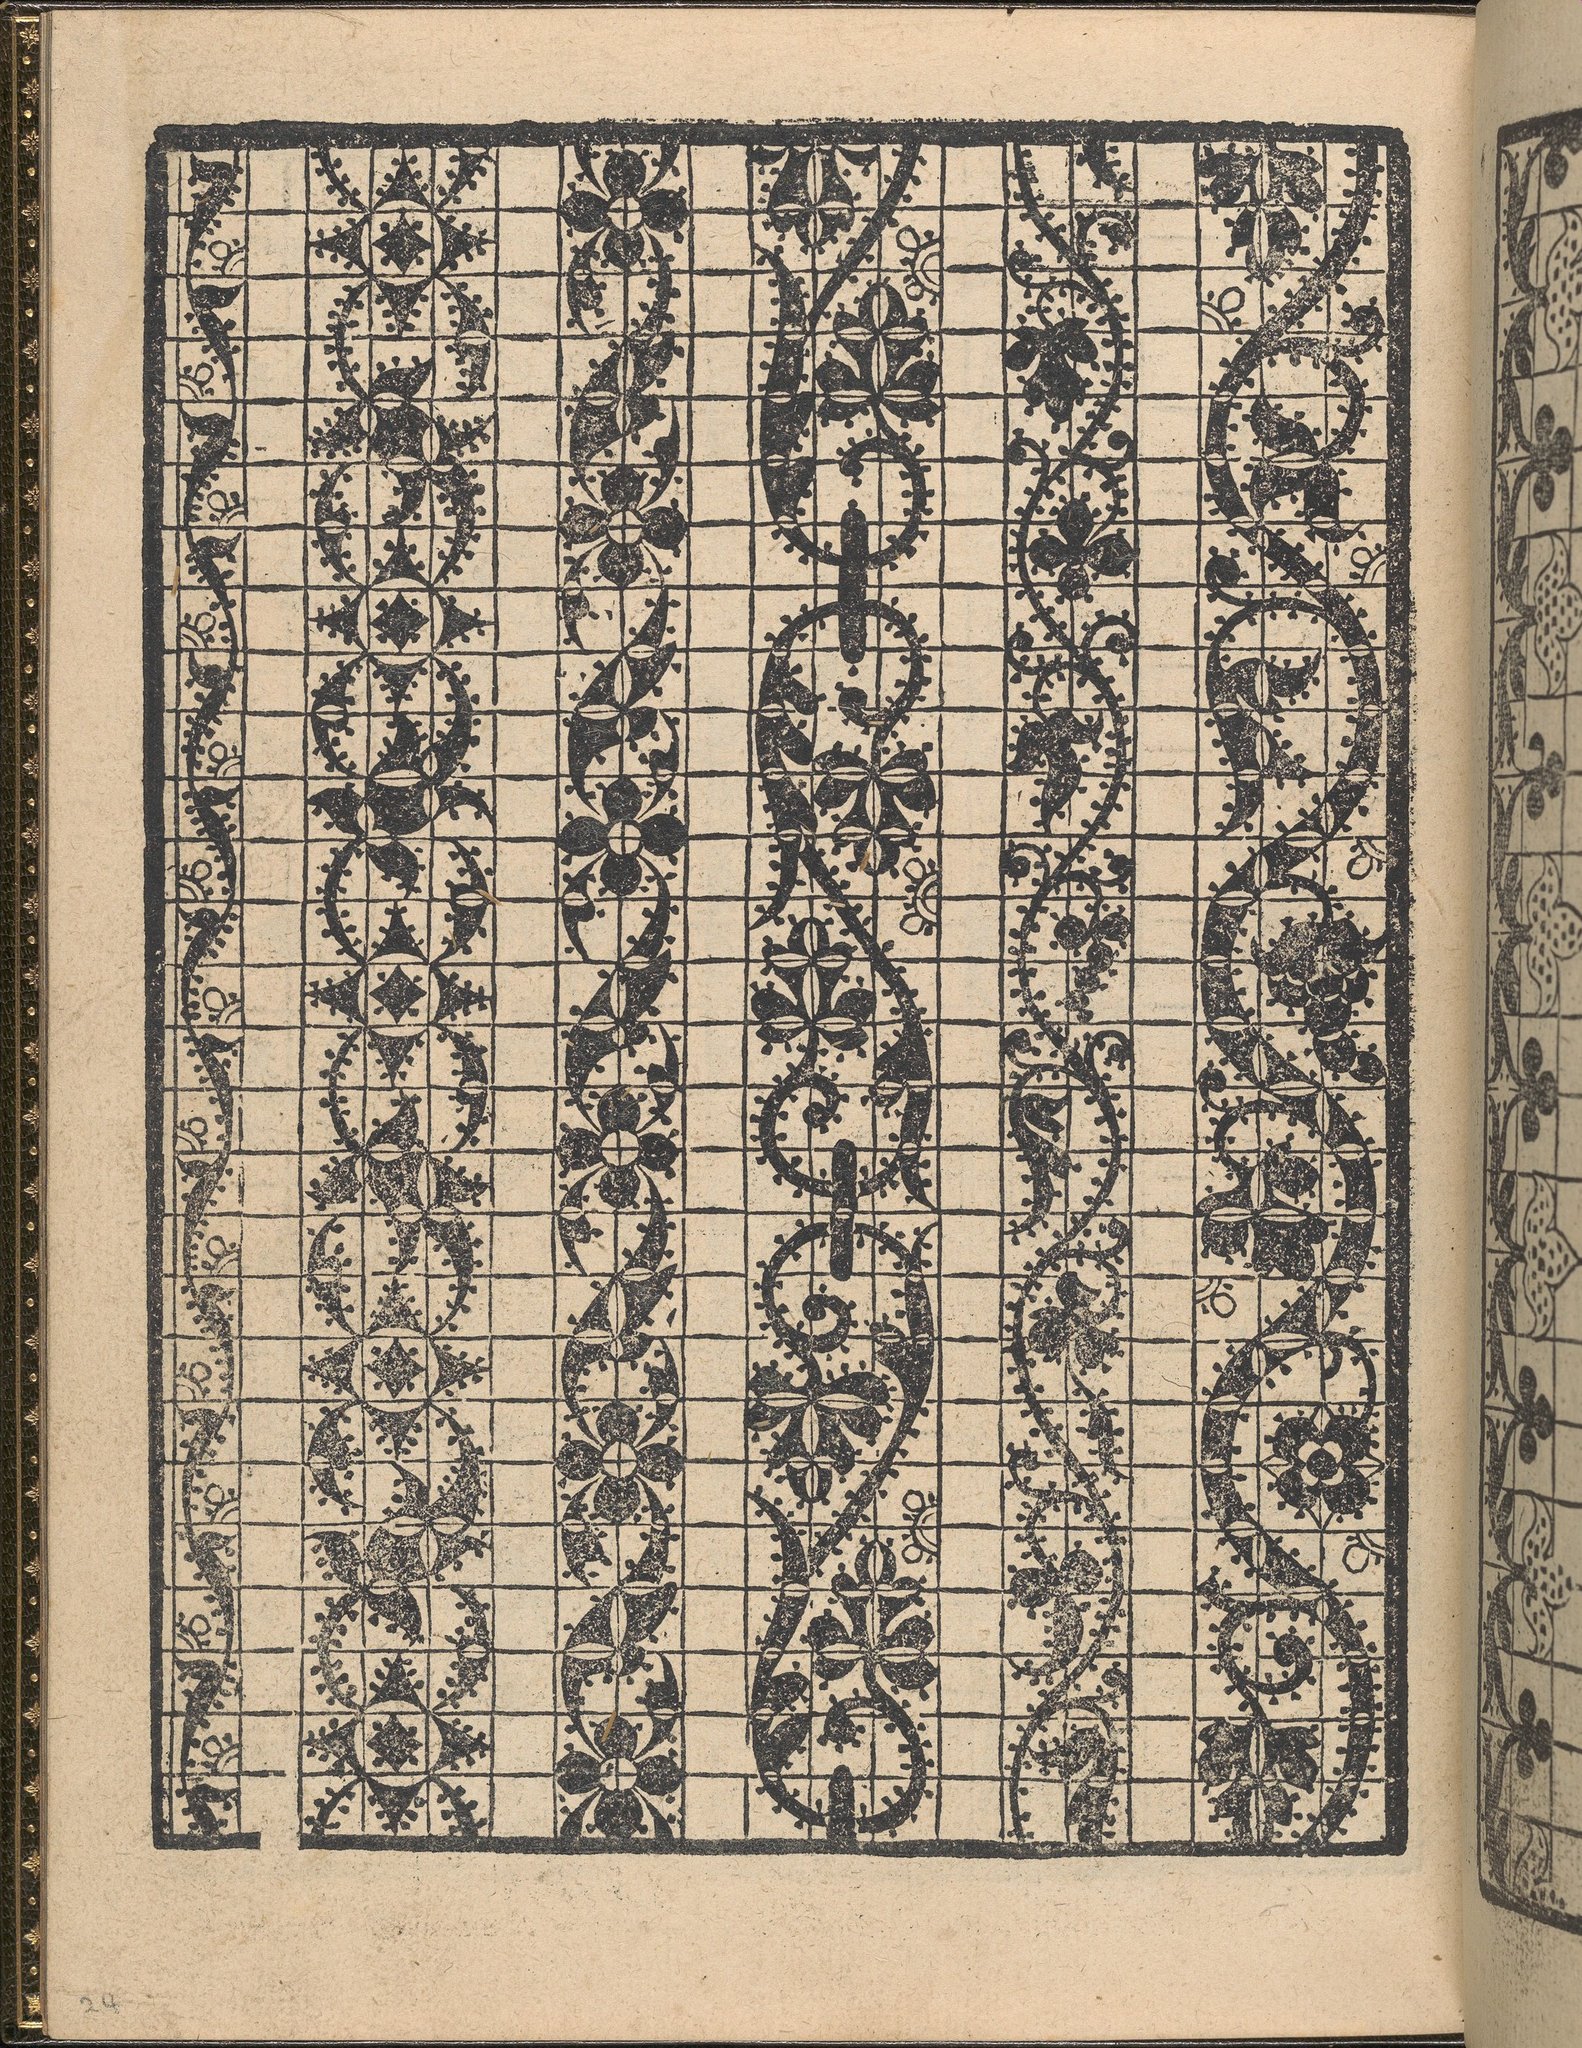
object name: book print ornament architecture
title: La Gloria et l'Honore di Ponti Tagliati, E Ponti in Aere, page 13 (verso)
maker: matteo pagano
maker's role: publisher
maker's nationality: italian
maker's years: 1515-1588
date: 1556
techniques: woodcut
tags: flowers,leaves,vines